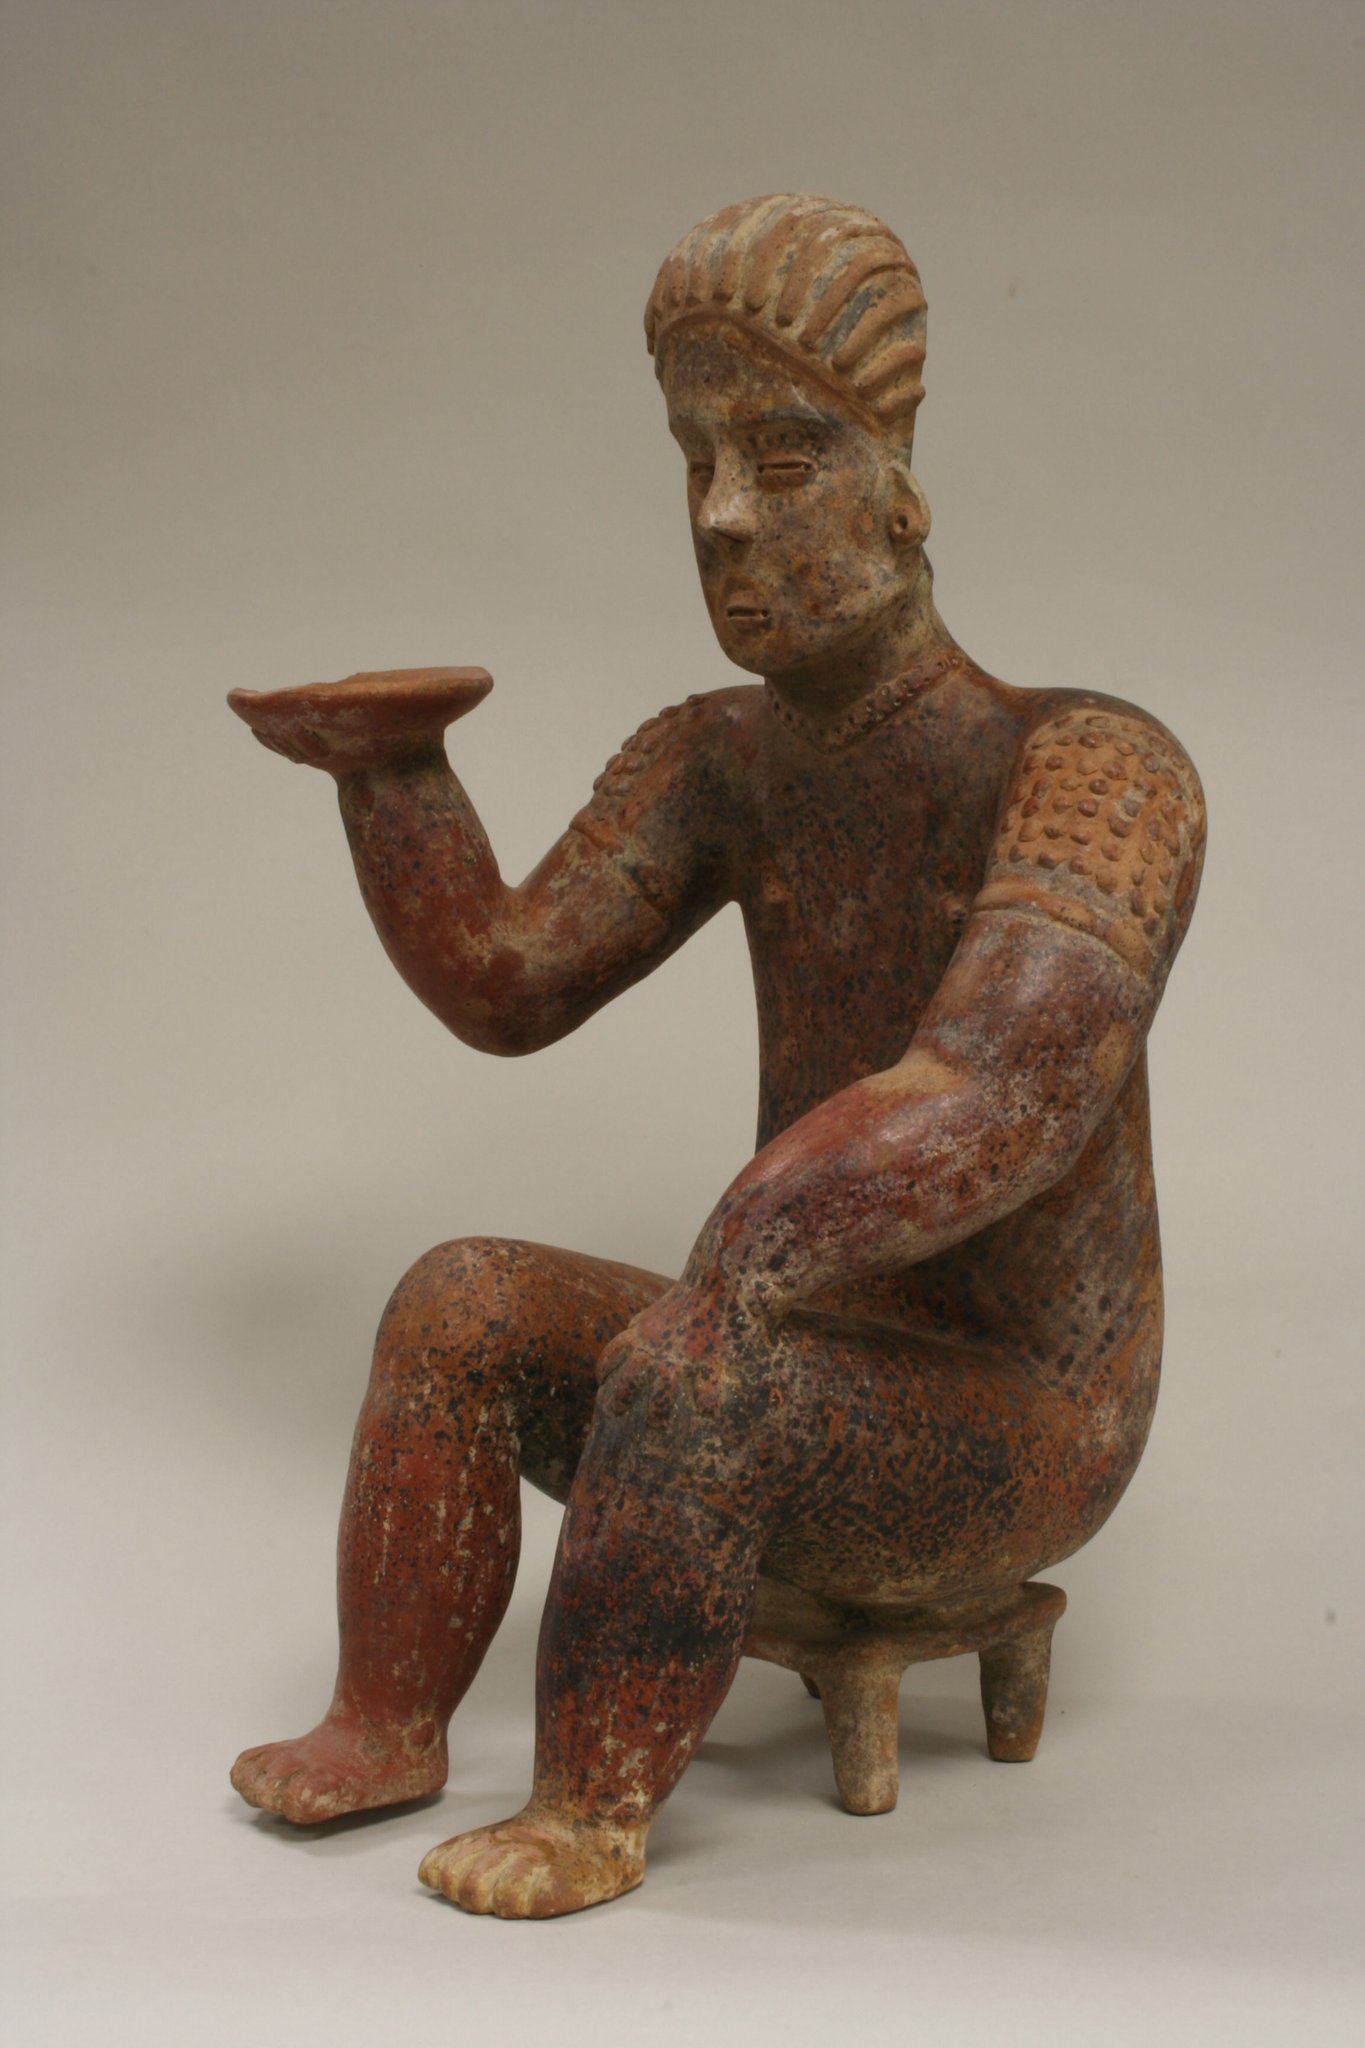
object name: female figure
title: Female Figure Seated on Stool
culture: colima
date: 101-500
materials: ceramic, pigment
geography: mexico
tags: women